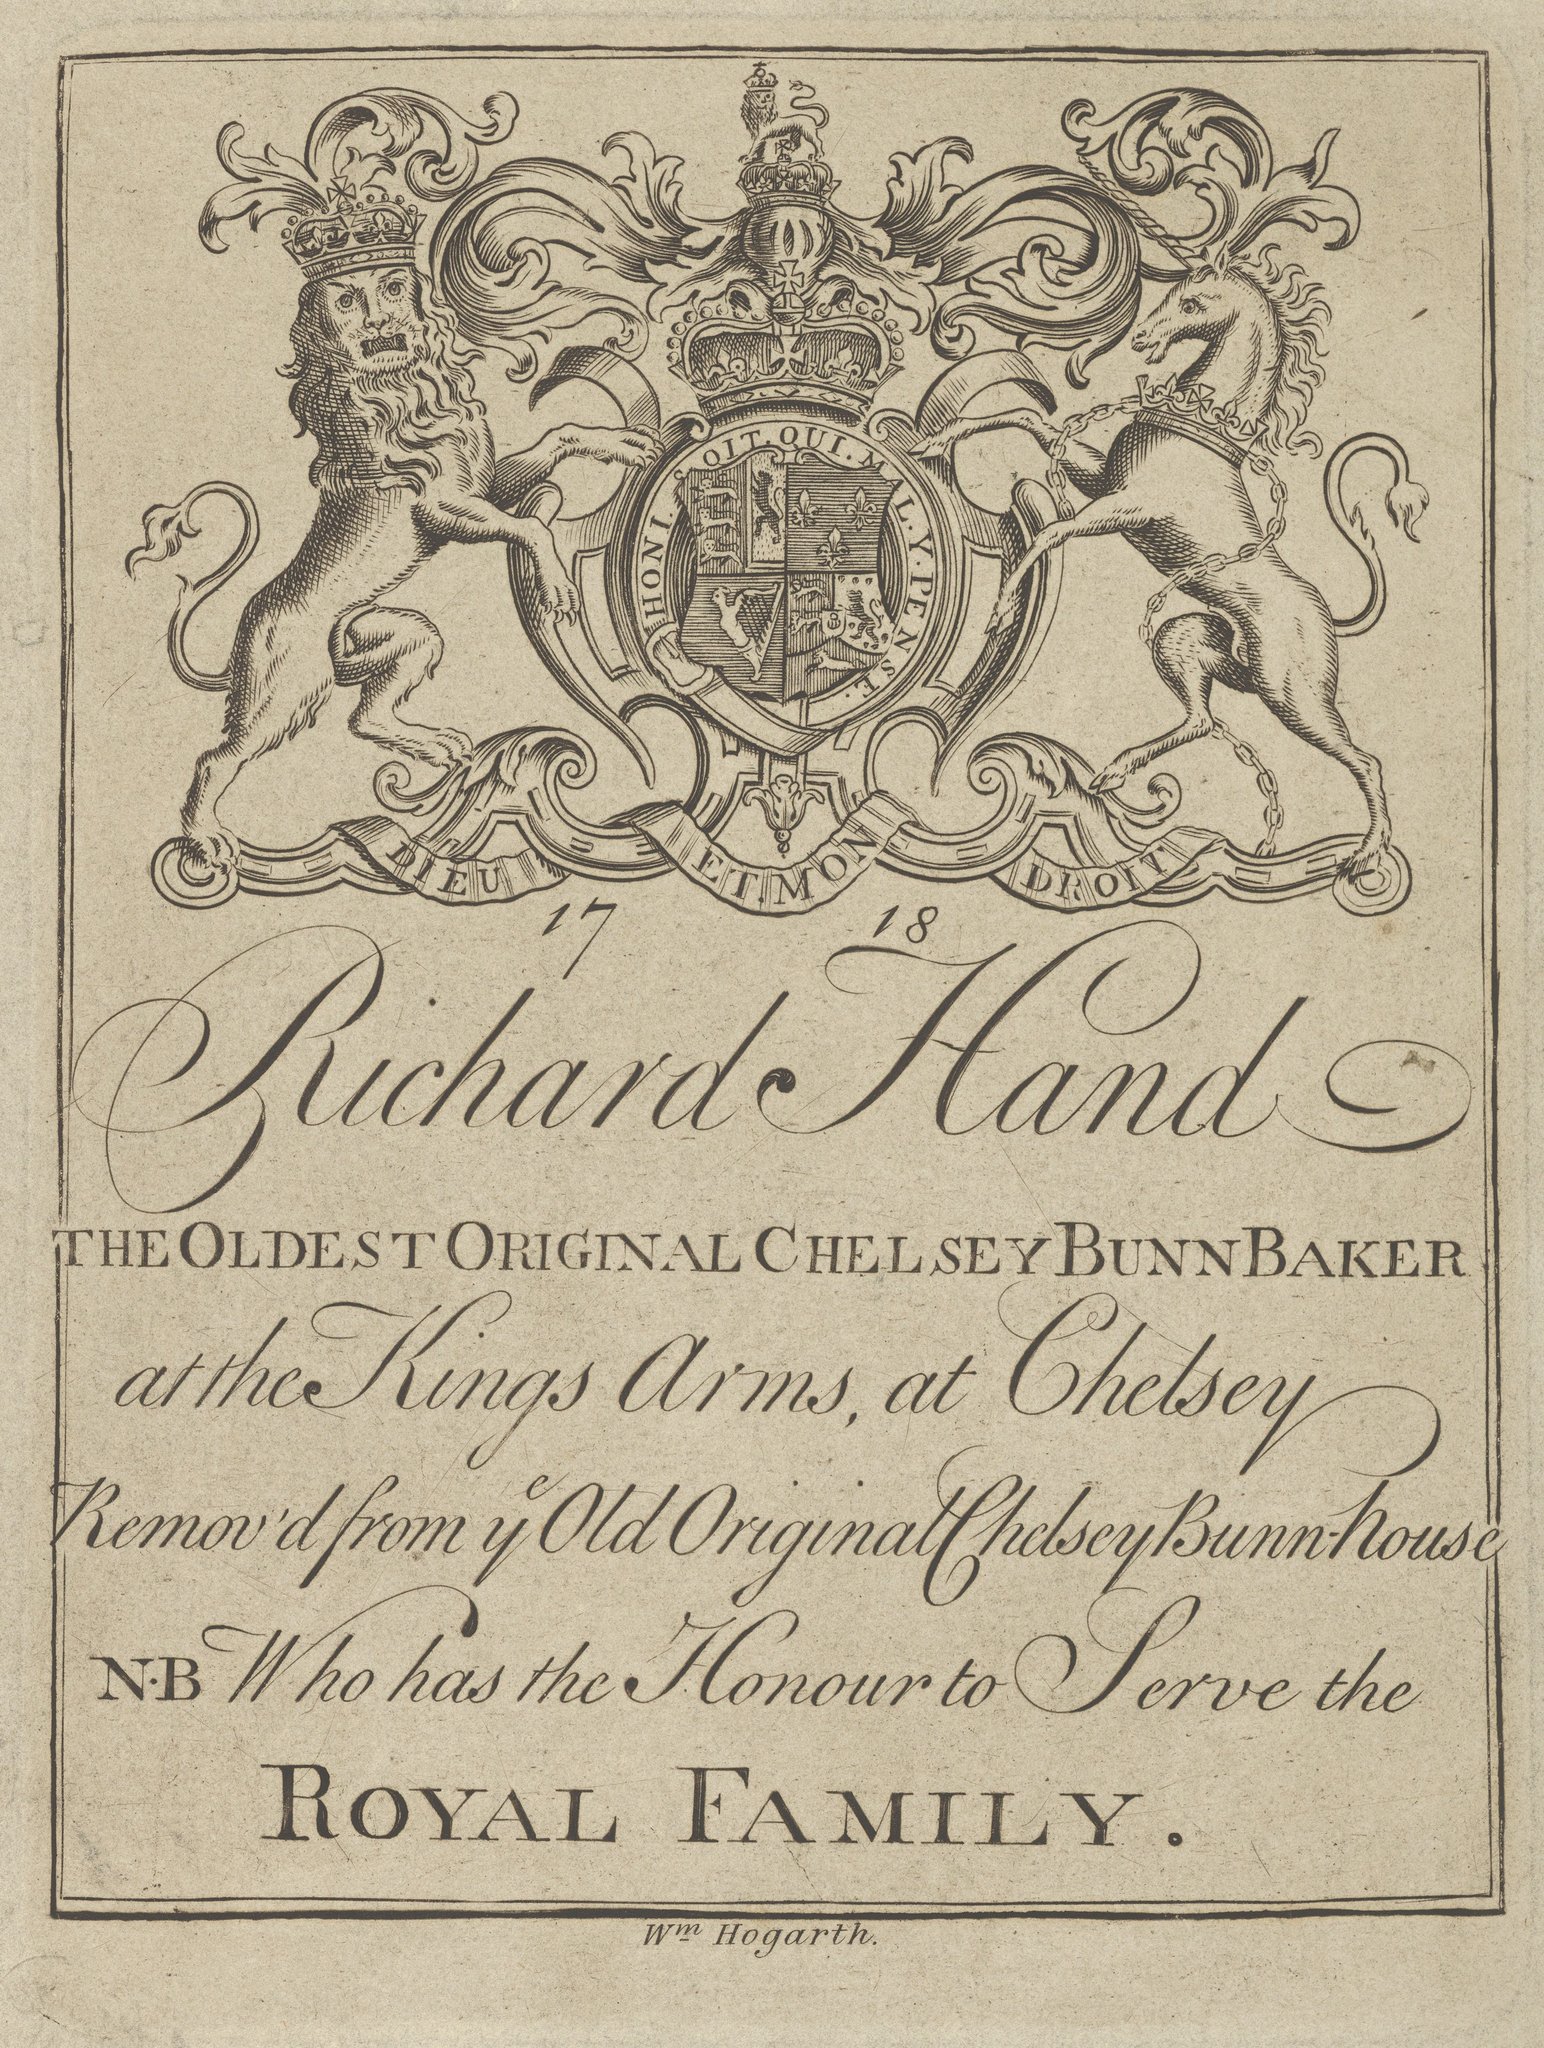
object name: print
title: Trade Card of Richard Hand, The Oldest Original Chelsey Bunn Baker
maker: william hogarth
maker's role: artist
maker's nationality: british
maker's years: 1697-1764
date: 1718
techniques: engraving, etching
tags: coat of arms